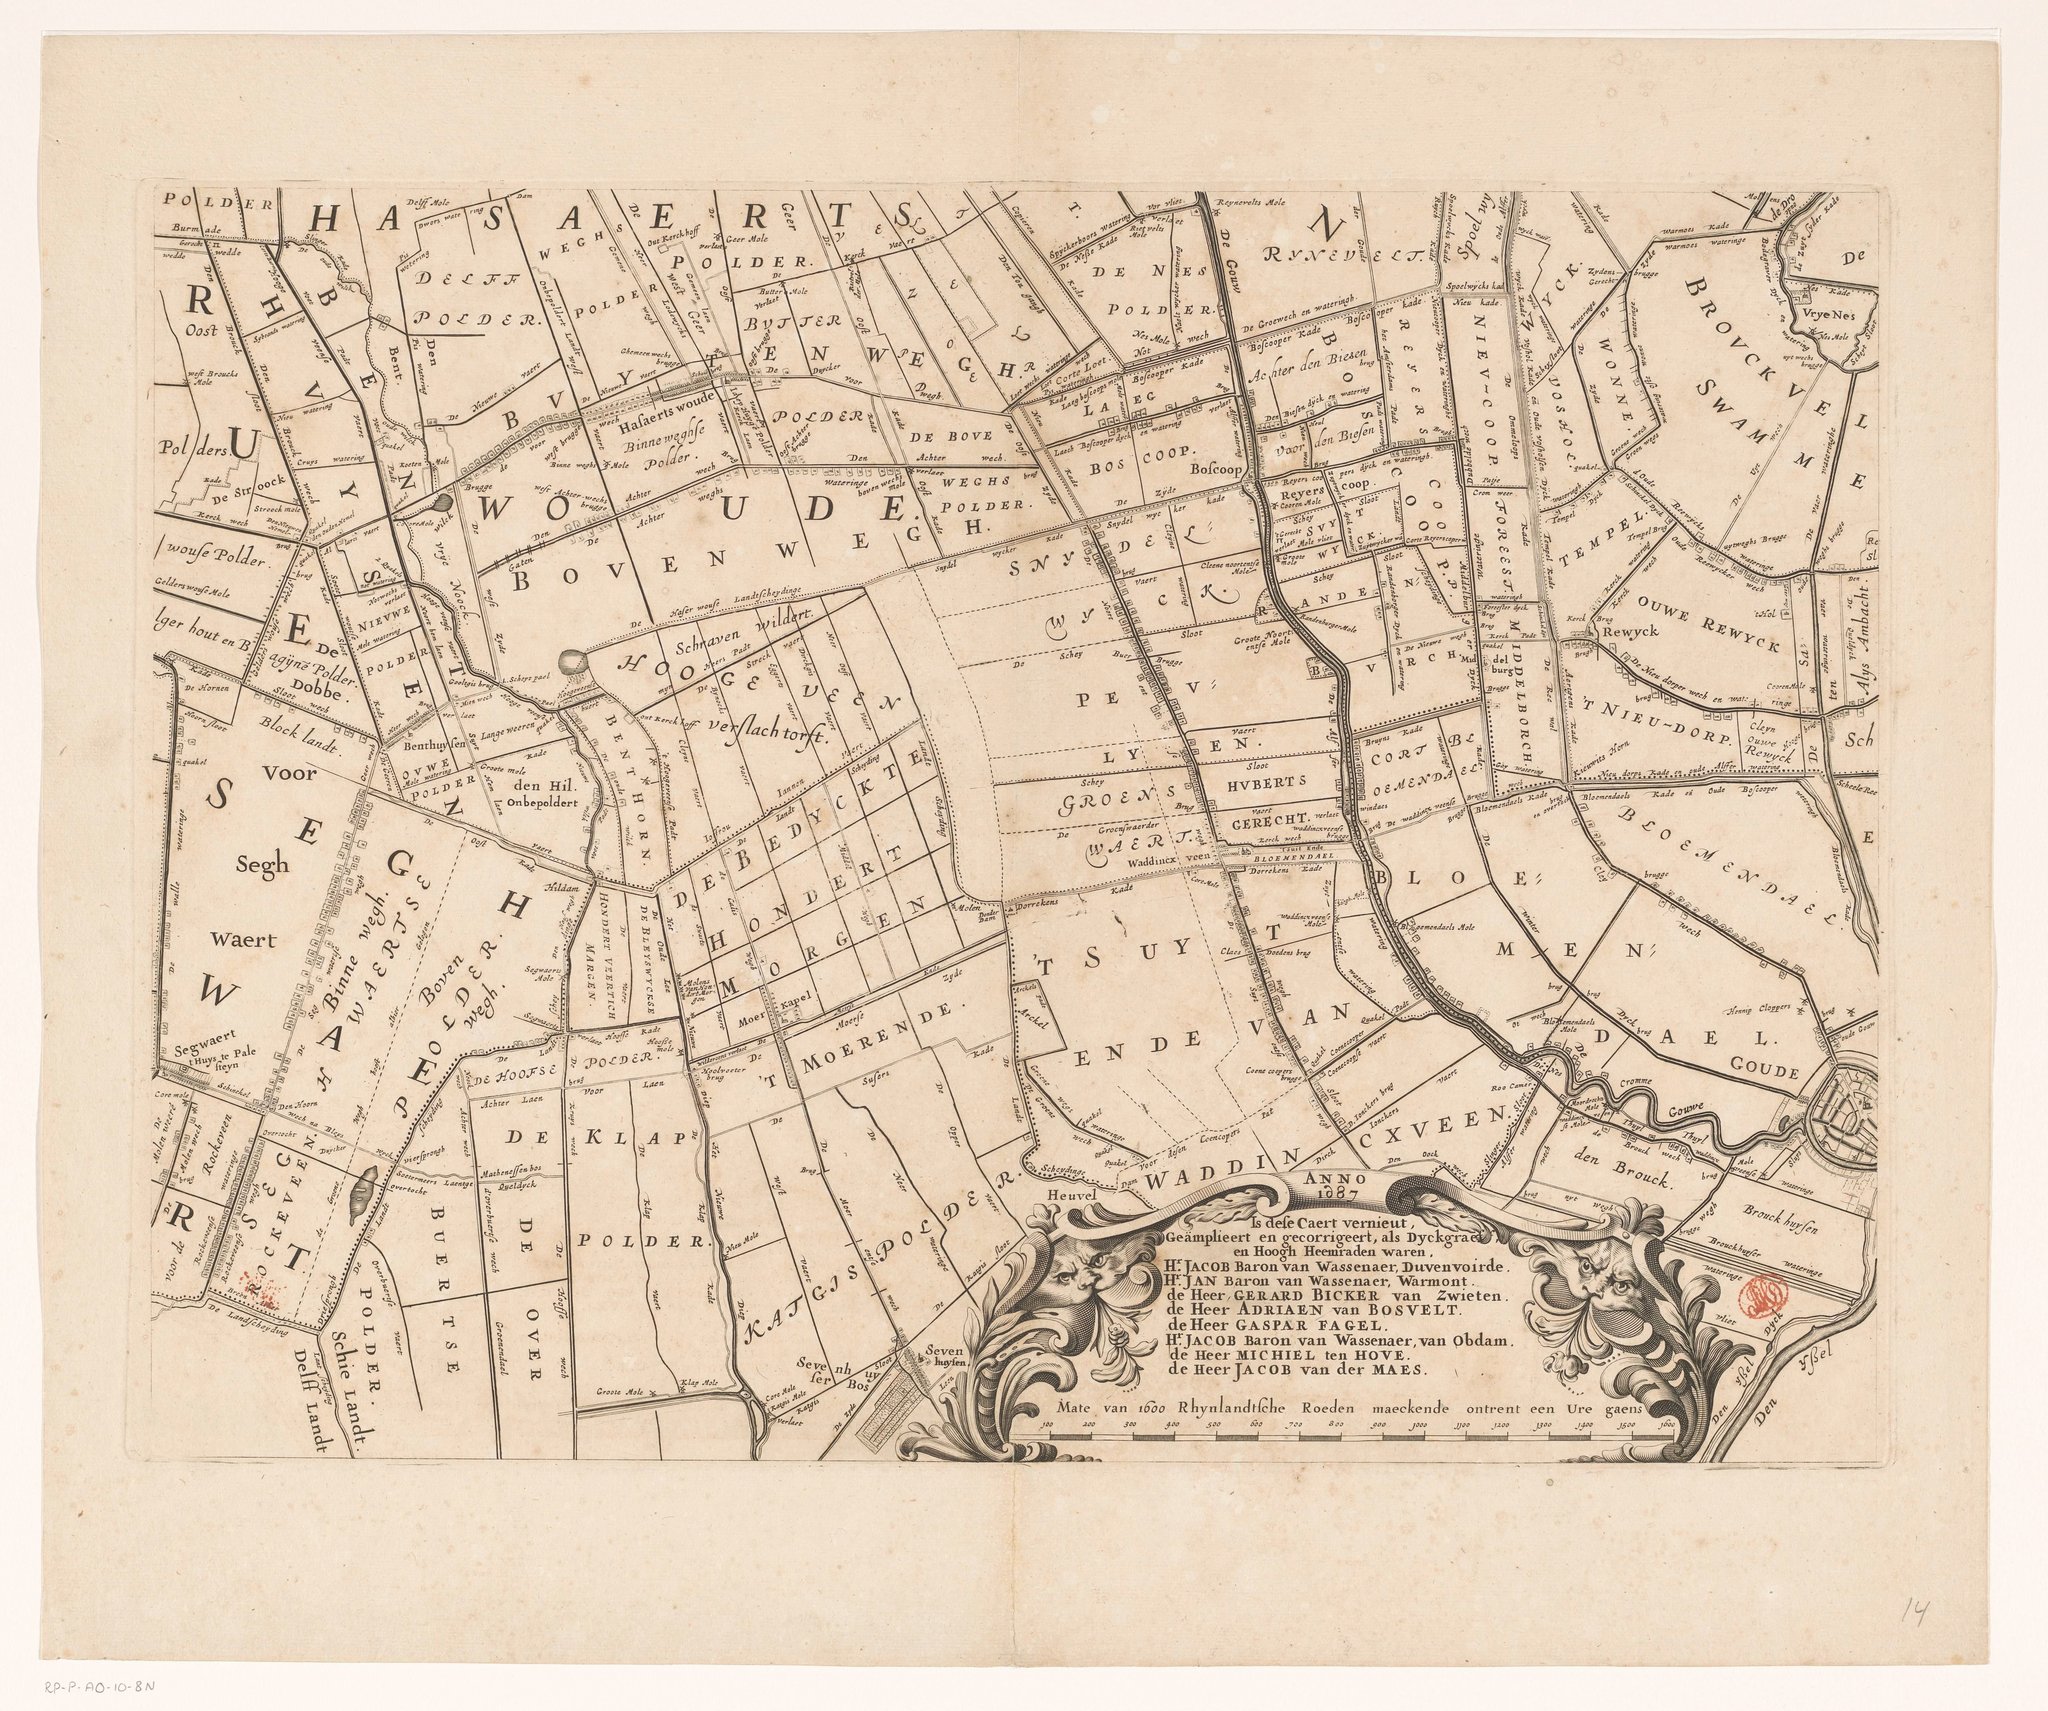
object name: print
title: Kaart van het Hoogheemraadschap van Rijnland (veertiende deel)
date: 1647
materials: paper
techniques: engraving, etching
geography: amsterdam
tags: maps of separate countries or regions, polder, reclaimed land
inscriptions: collector's mark: Lugt 195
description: Deze prent behoort tot de tweede druk (1687) van 'T' Hoogheymraedschap van Rhynland', een wandkaart van het Hoogheemraadschap van Rijnland bestaande uit een kaart van het gebied en een sierrand. Van deze kaart zijn voor zover na te gaan drie verschillende drukken bekend, uit respectievelijk 1647, 1687 en 1746. Het kaartdeel is gedrukt van twaalf platen die voor elke druk zijn aangepast. Het vijfde blad van het kaartdeel (RP-P-AO-10-8H) is in of na 1766 nog een keer bijgewerkt en los uitgegeven. Hierdoor zijn van het vijfde blad vier staten bekend en van de overige bladen drie. Zie documentatie voor meer informatie. Bij de eerste en tweede druk hoort een sierrand met daarop de titel, wapenschilden en octrooiverleningen. Delen van de zijkant van de rand van de eerste druk zijn voor de tweede druk herbruikt, terwijl andere delen van de zijkanten en de hele bovenkant nieuw zijn gemaakt door Romeyn de Hooghe. De derde druk heeft slechts een nieuw gemaakte titelstrook langs de bovenkant.